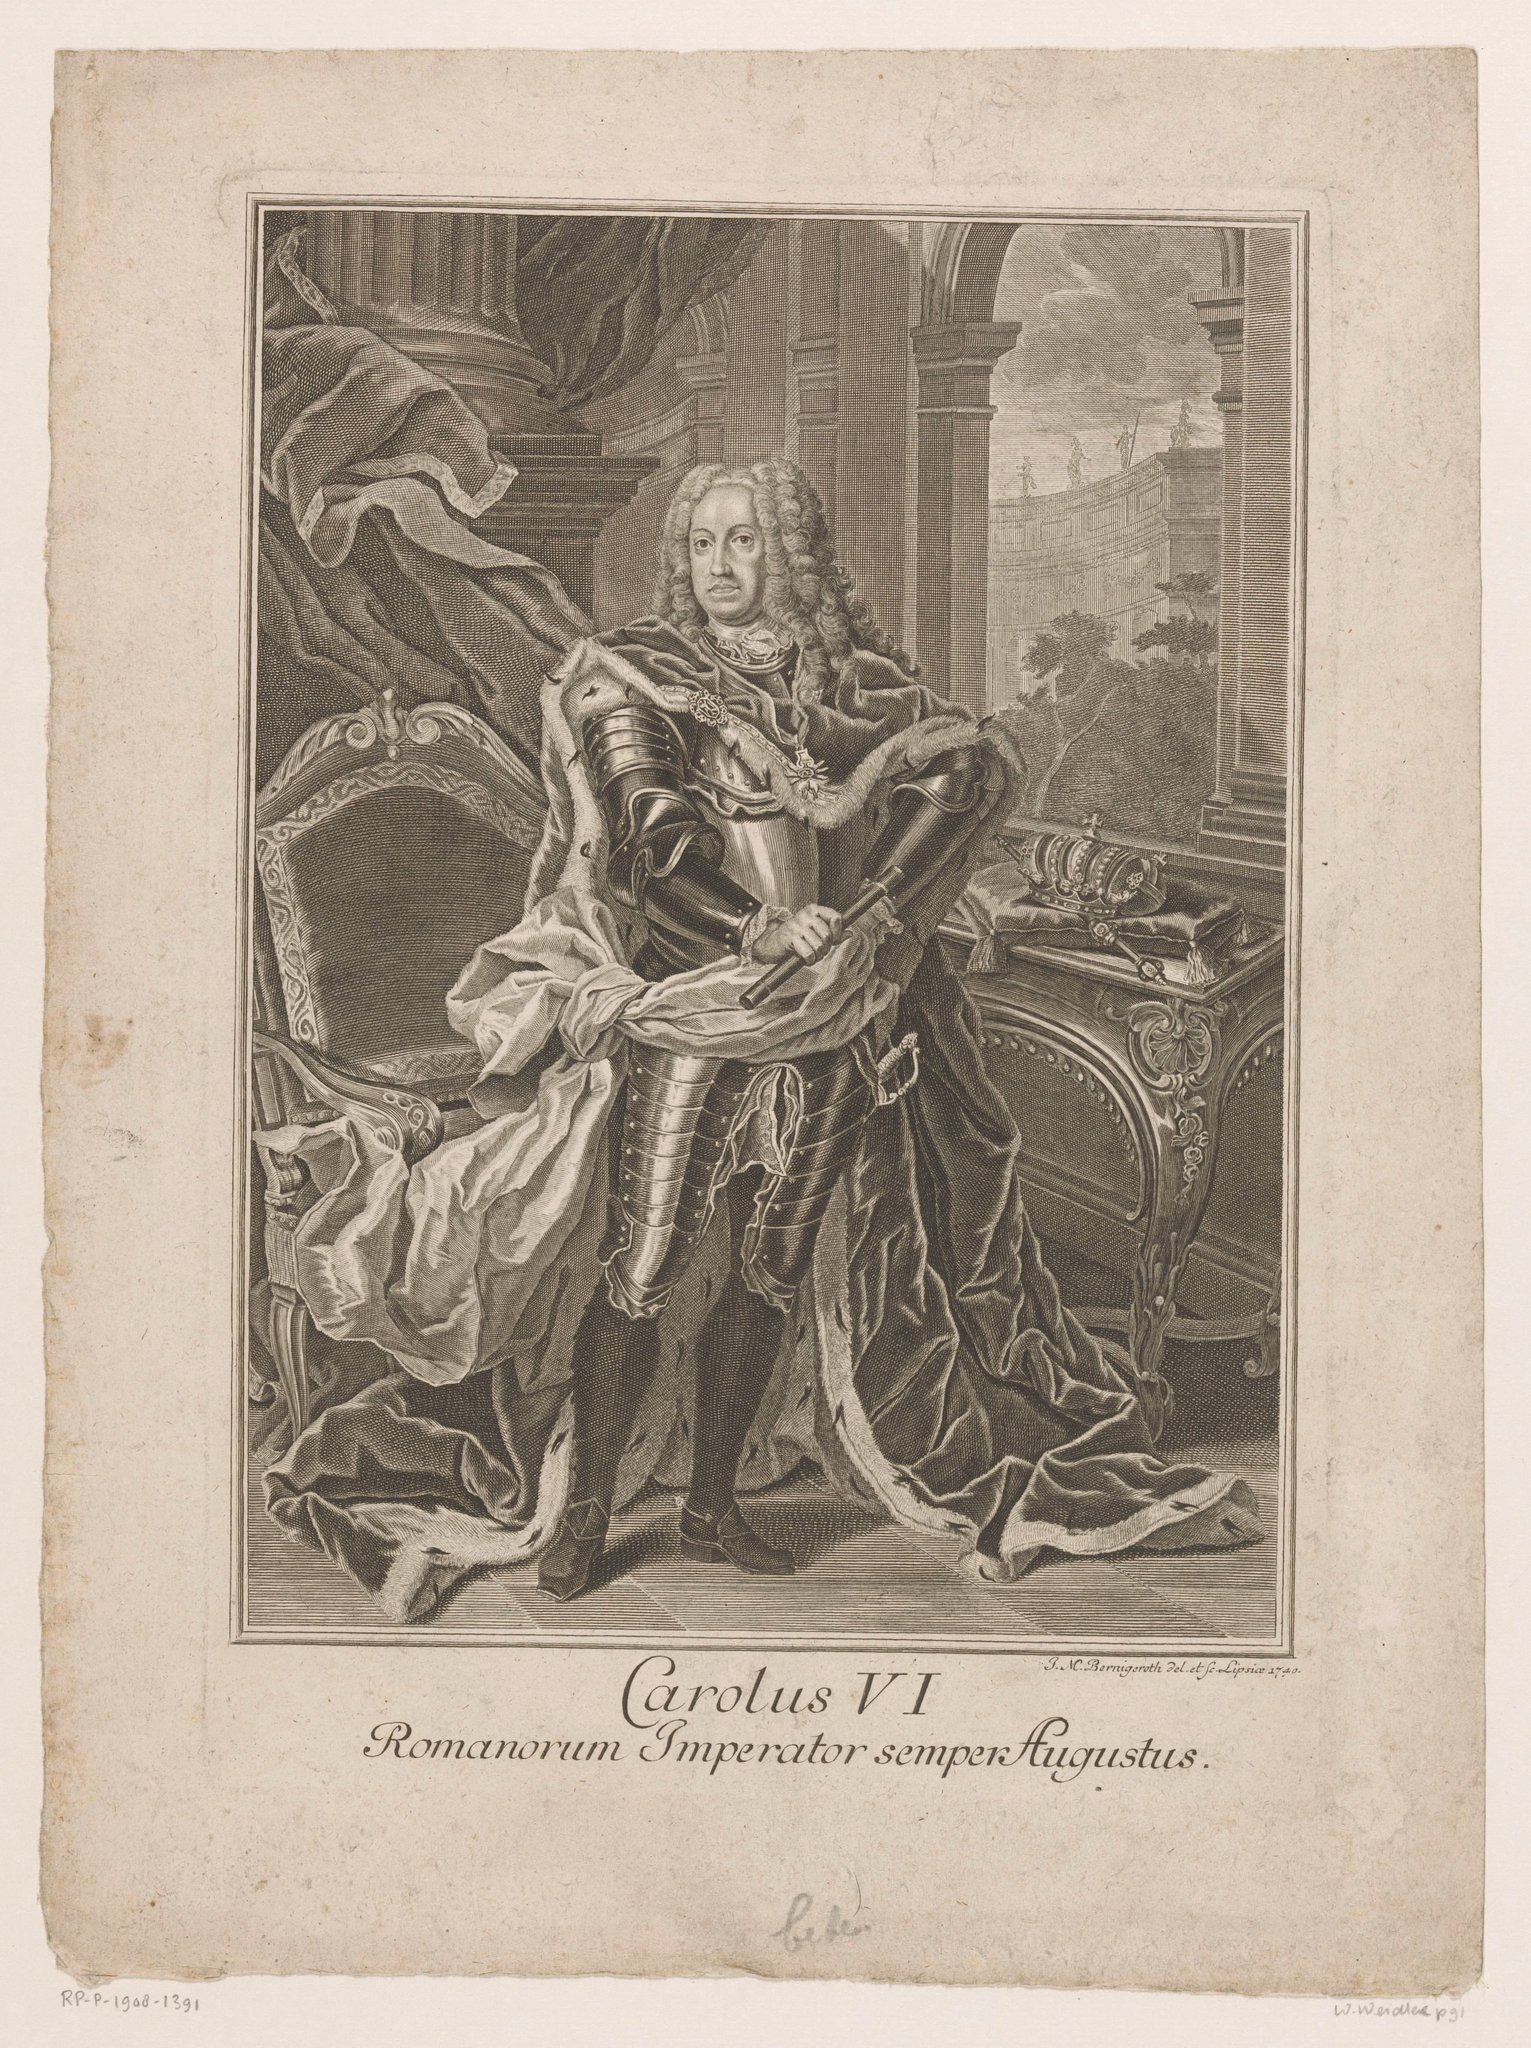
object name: print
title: Portret van keizer Karel VI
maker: johann martin bernigeroth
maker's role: print maker, publisher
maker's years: 1713-1767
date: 1740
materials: paper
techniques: engraving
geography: leipzig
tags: vienna, charles vi (holy roman emperor), armour, historical persons, knighthood order of the golden fleece - insignia of a knighthood order, e.g.: badge, chain (with name of order), baton of general, insignia and symbols of sovereignty (crown, diadem, sceptre, orb, seal, standard, cloak, pectoral)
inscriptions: collector's mark: Lugt 2228